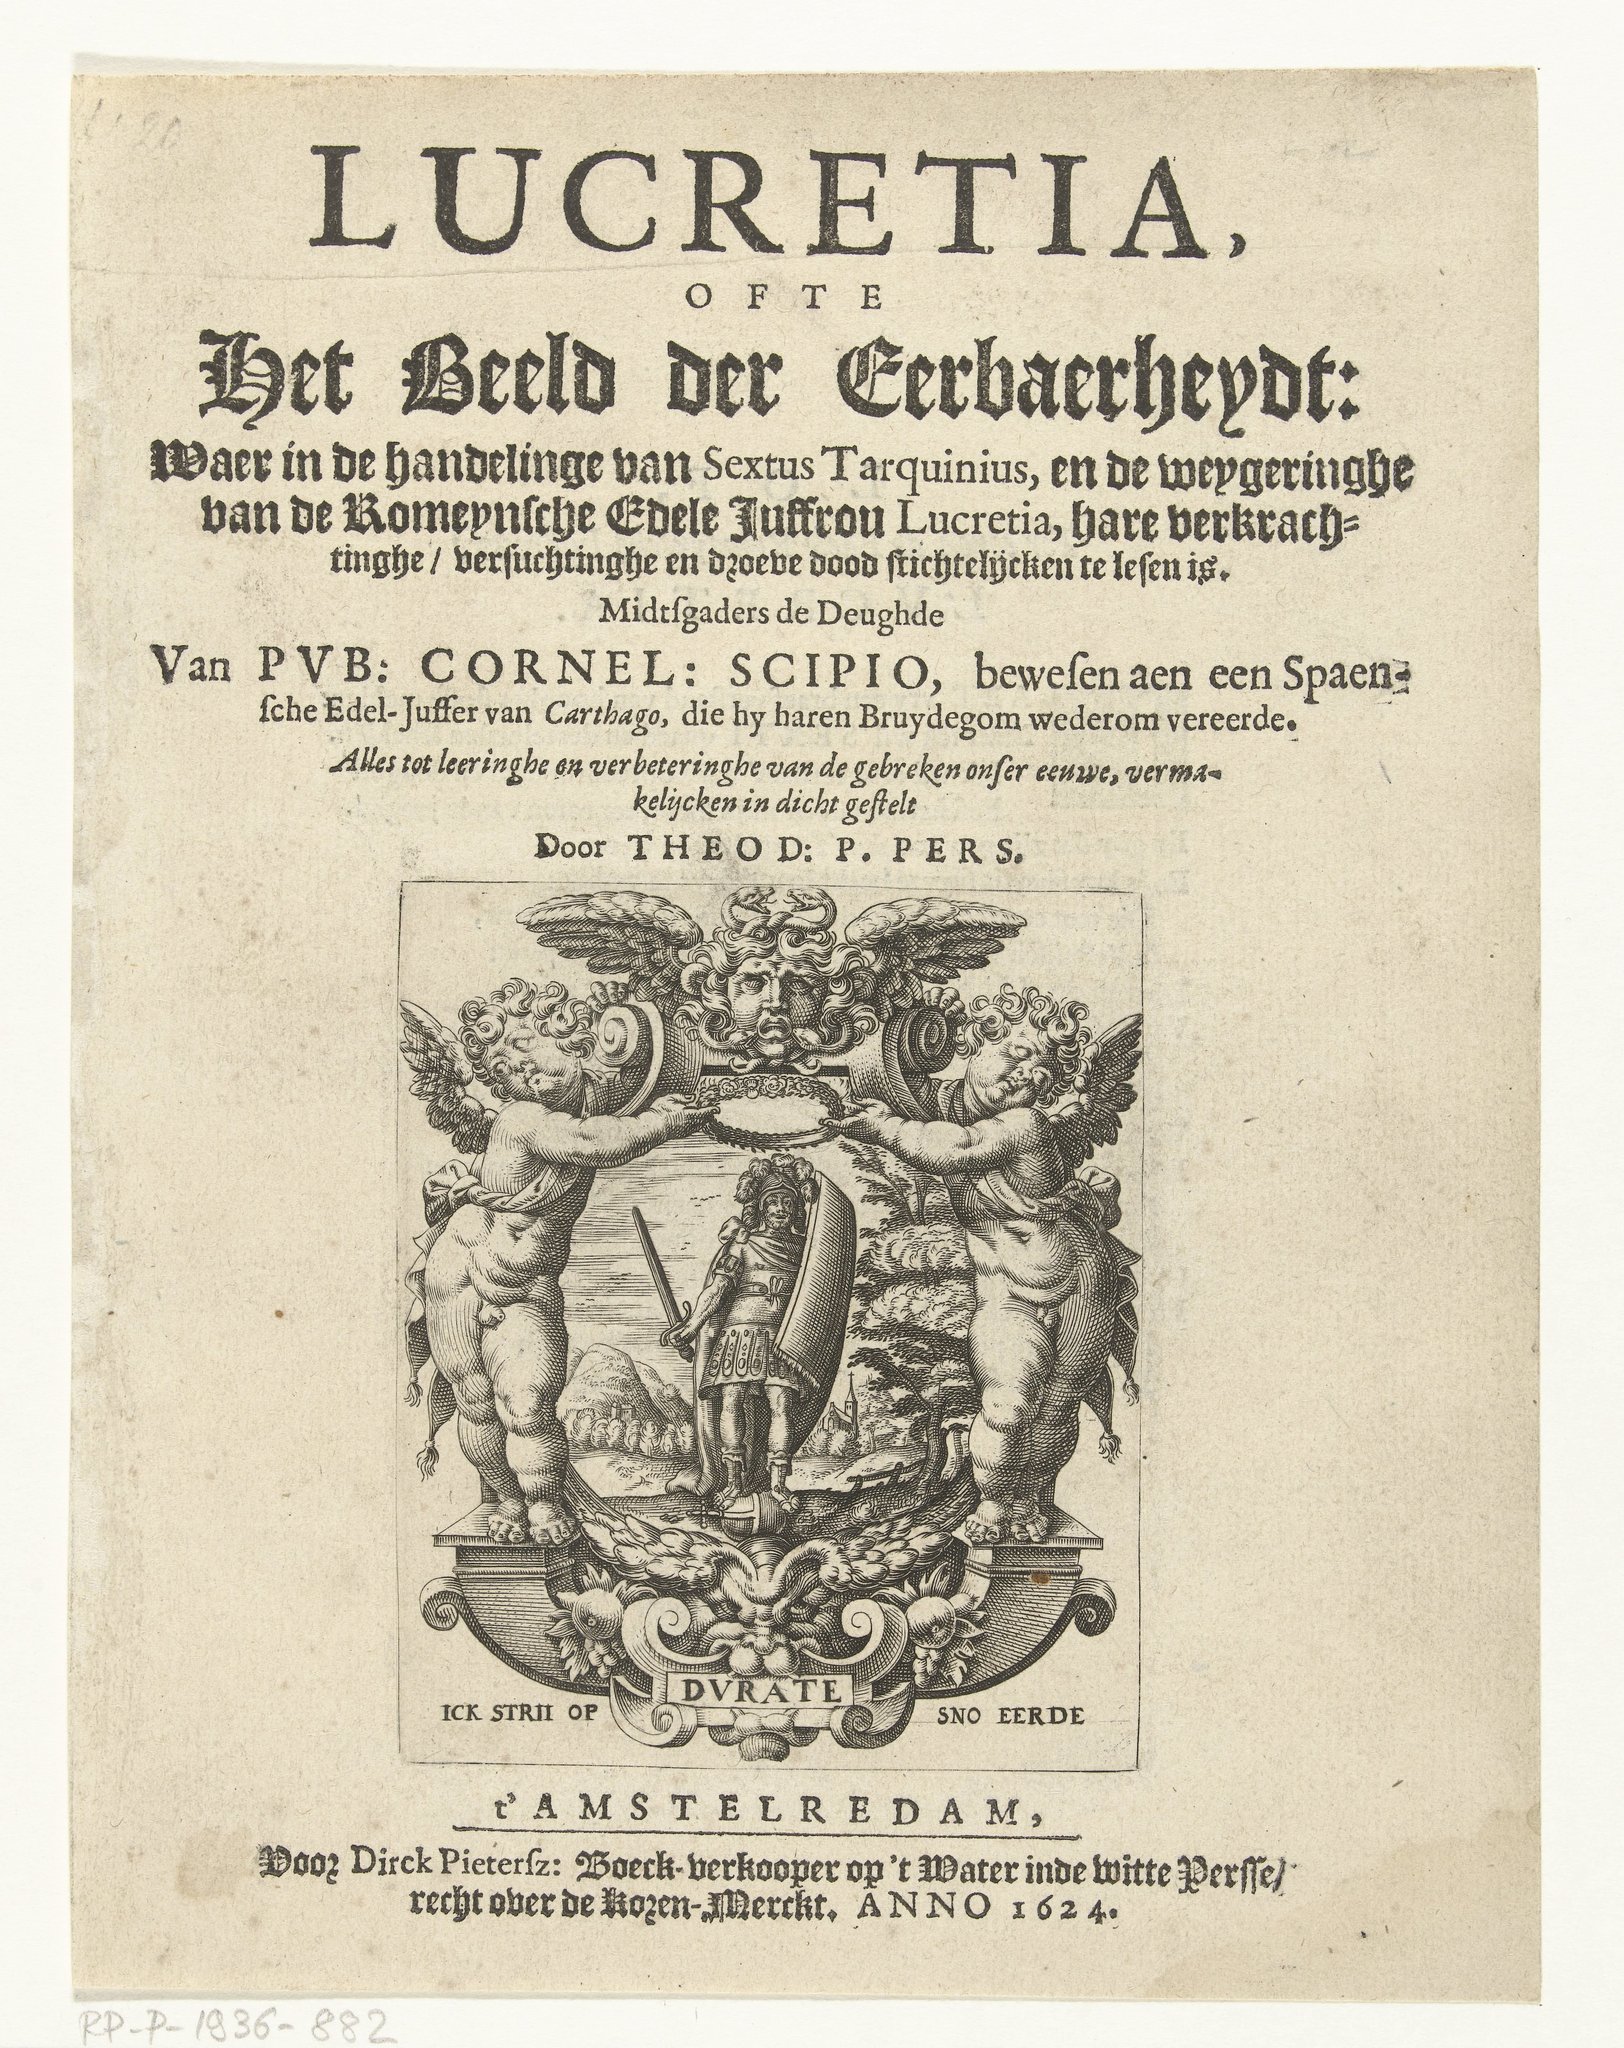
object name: print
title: Titelpagina voor: Dirck Pietersz. Pers, Lucretia, ofte Het beeld der eerbaerheydt. Amsterdam: 1624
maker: dirck pietersz. pers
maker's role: publisher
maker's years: 1581-1662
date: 1624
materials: paper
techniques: engraving, letterpress printing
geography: amsterdam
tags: title-page, device (trade-mark of printer or publisher)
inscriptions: collector's mark: Lugt 2760, collector's mark: Lugt 2228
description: Titelpagina met drukkersmerk van Dirck Pietersz. Pers. Op het drukkersmerk zijn anagram: Ick strii op sno eerde, en een ridder die op een wereldbol staat en door twee putti gelauwerd wordt.